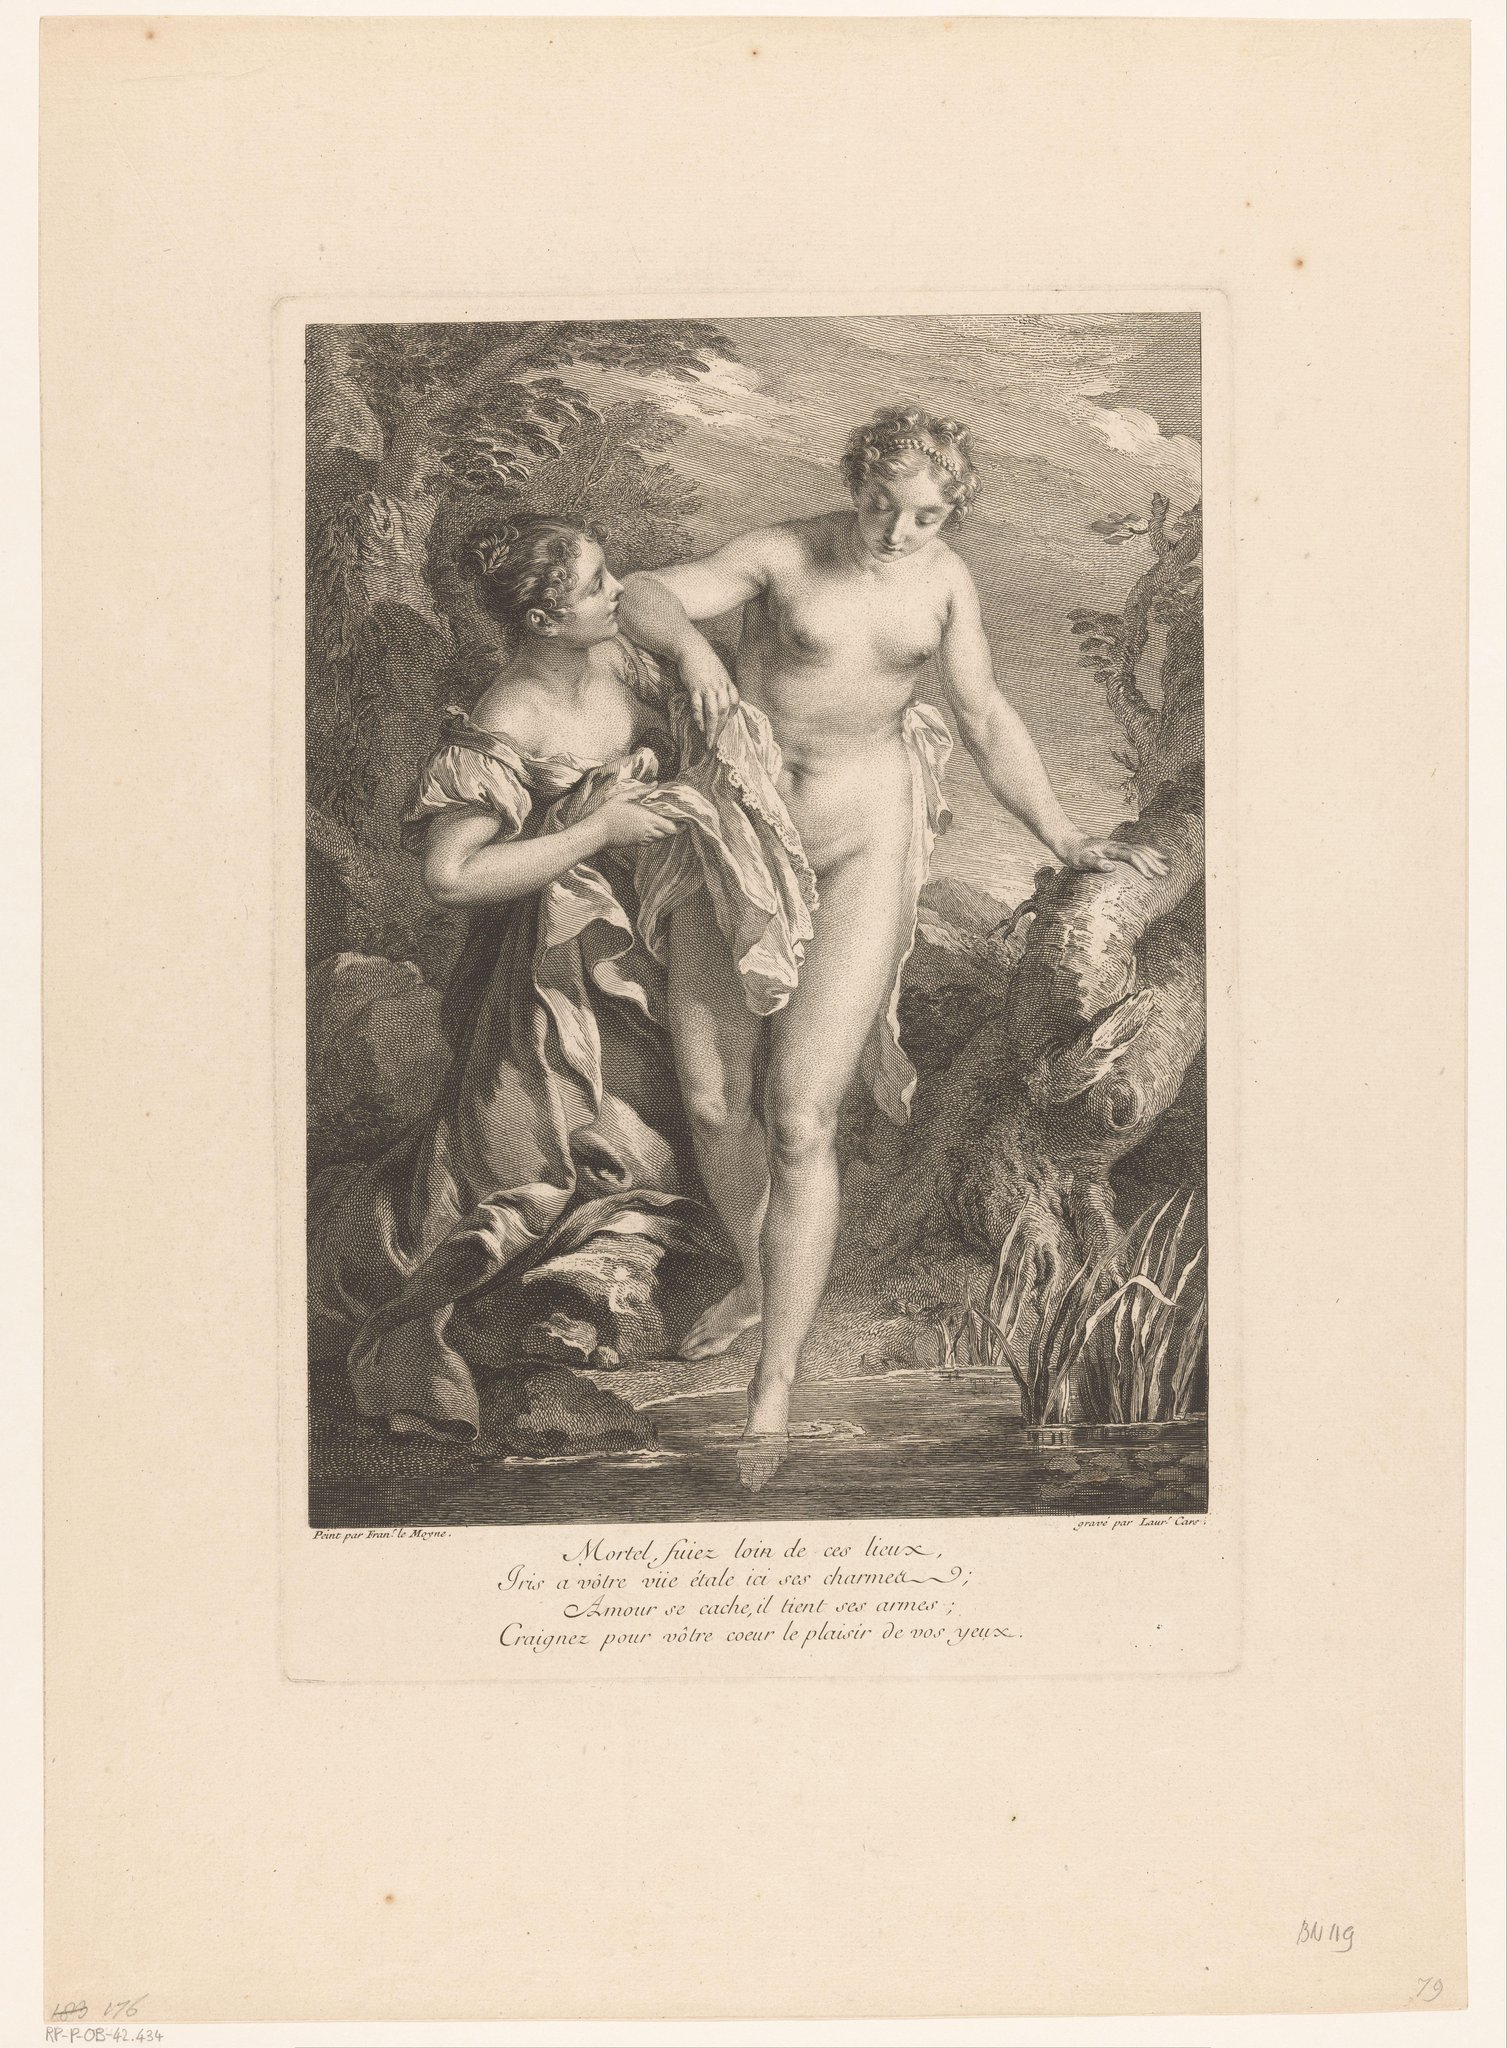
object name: print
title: Badende Iris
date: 1709-1771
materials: paper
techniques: engraving, etching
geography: italy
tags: taking a bath - aa - in the open air, iris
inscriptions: collector's mark: Lugt 240